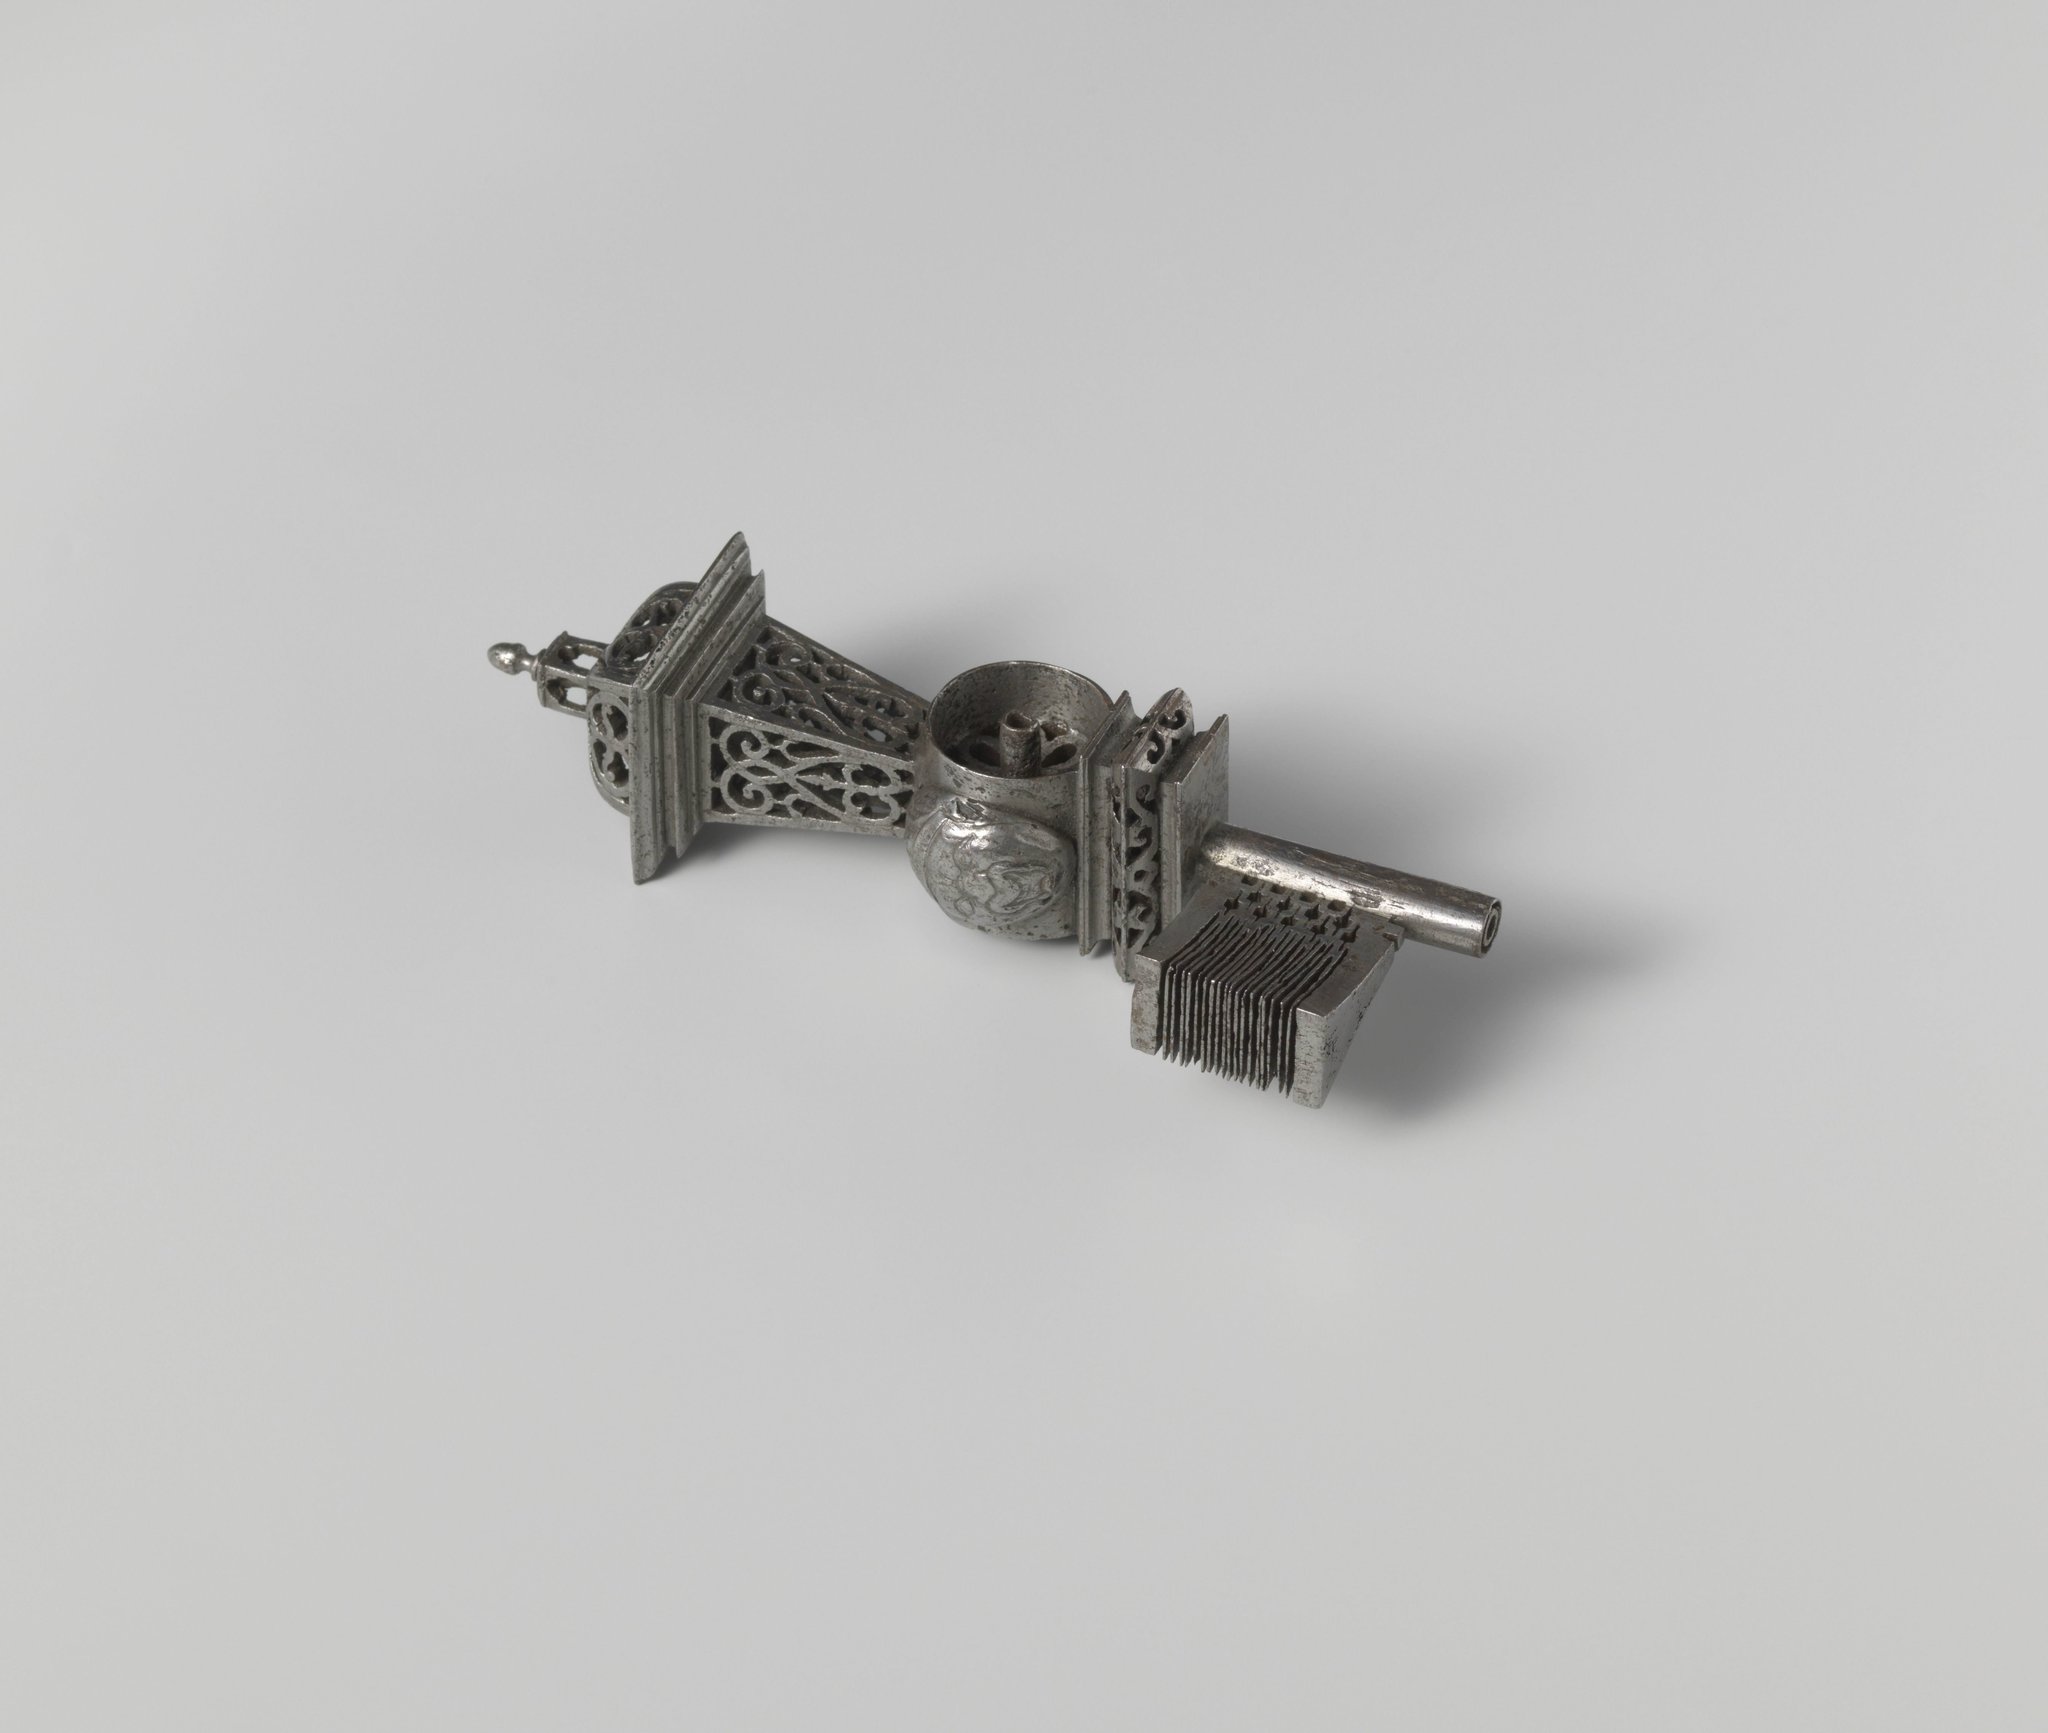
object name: key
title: Sleutel van ijzer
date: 1500-1600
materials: iron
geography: france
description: Gesmeed ijzeren sleutel. Geheel opengewerkt. Aan de ring twee maskers. De baard in een twintigtal dunne bladen gedeeld. Waarschijnlijk gilde proefstuk.